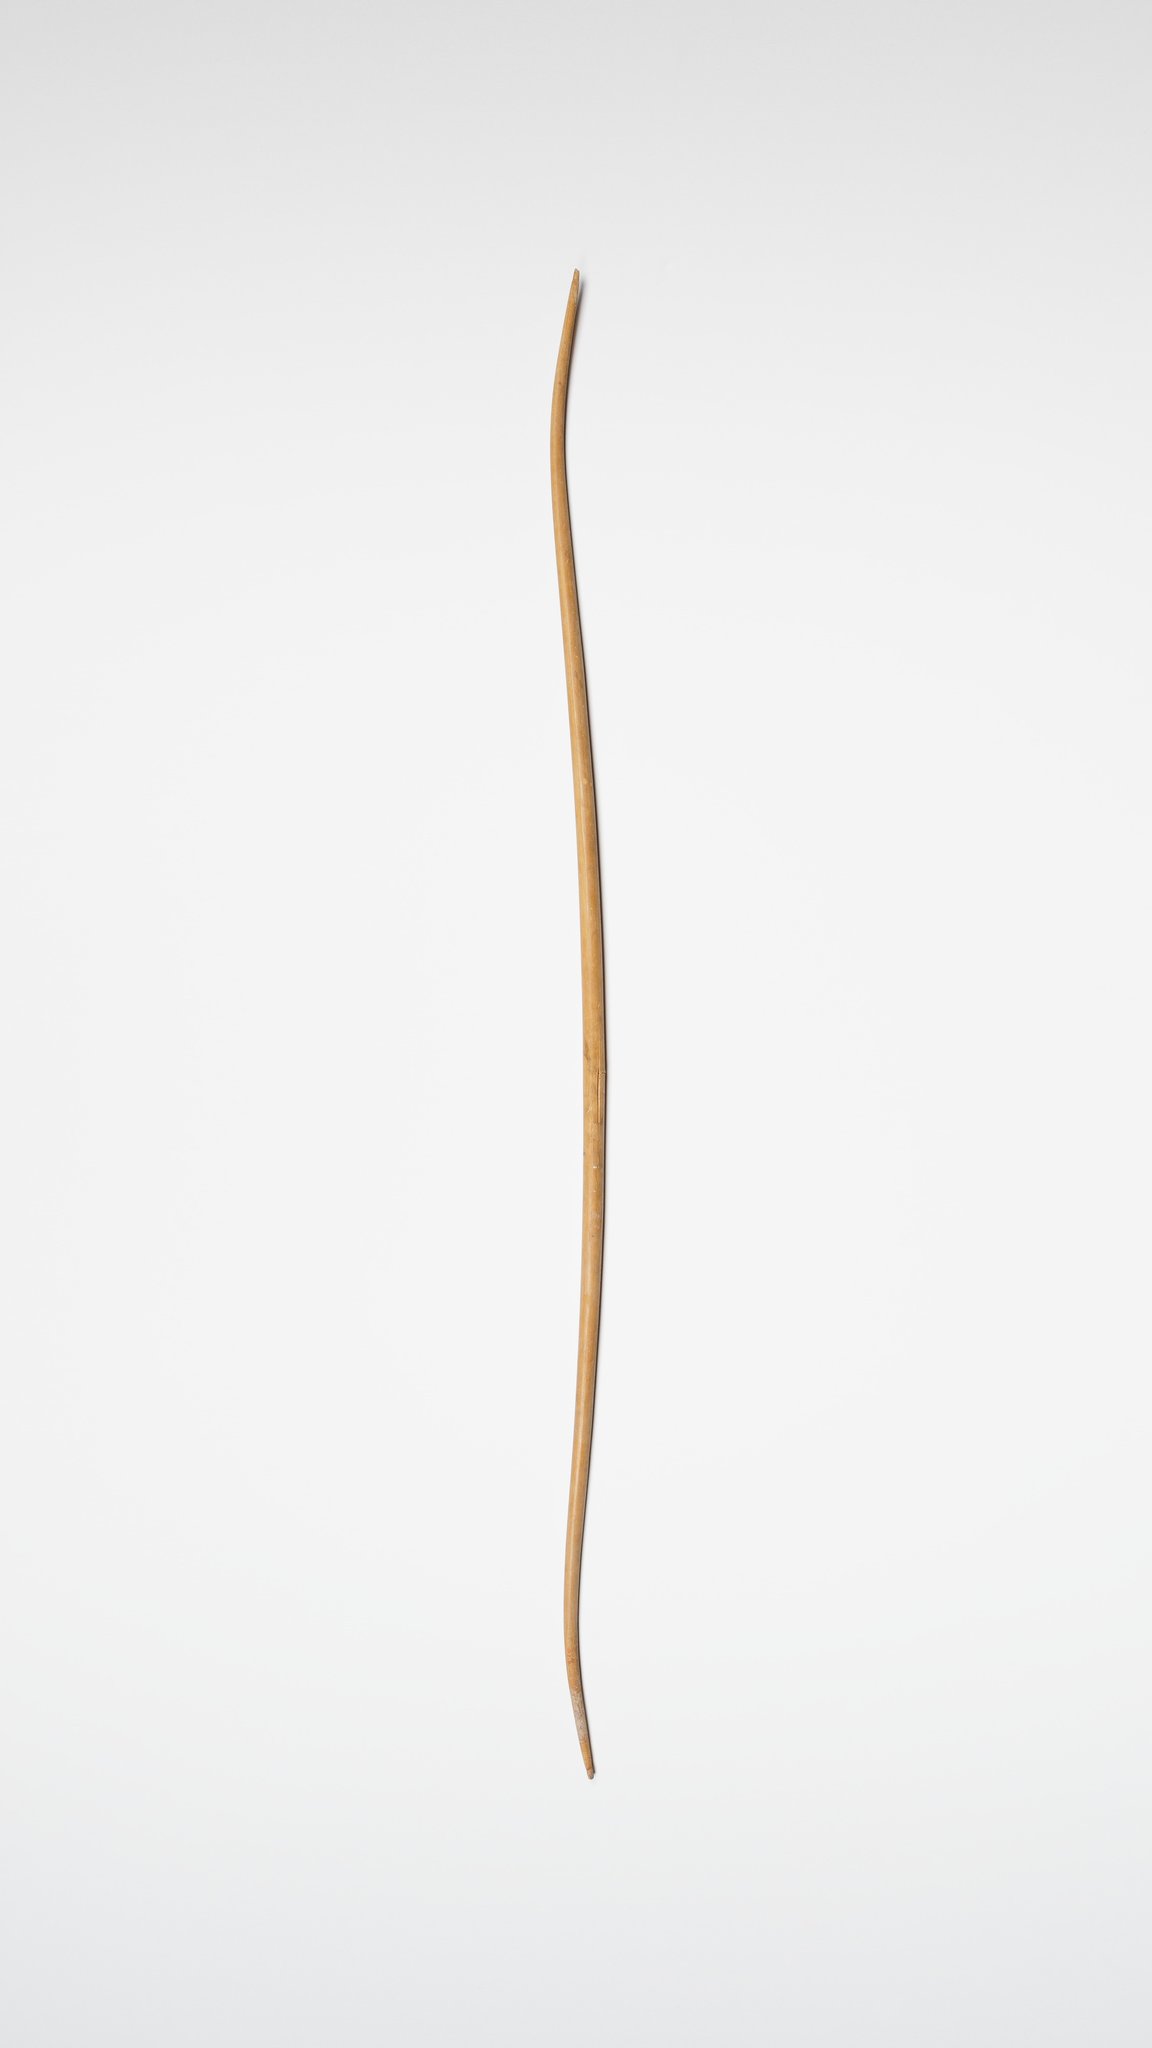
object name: bow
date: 2030-1650 BCE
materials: wood